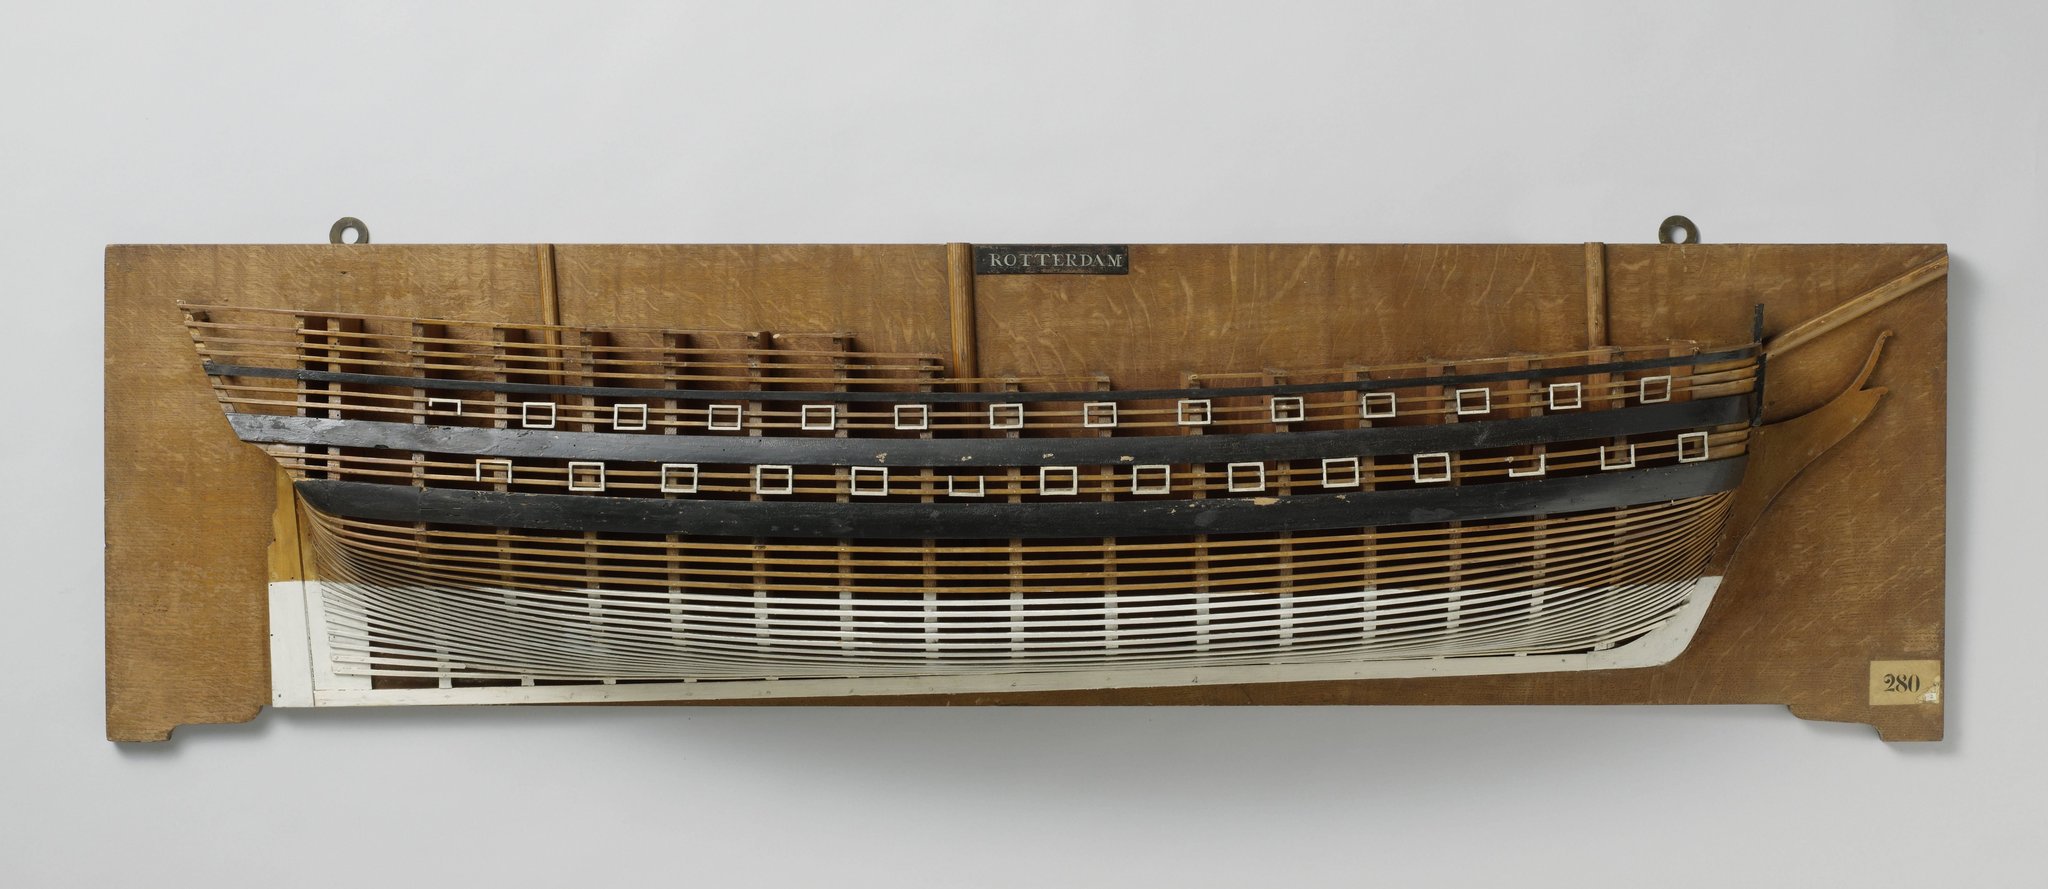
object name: ship model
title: Half Model of a 90-Gun Ship of the Line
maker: Anonymous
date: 1804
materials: wood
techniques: polychromy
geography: netherlands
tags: piet hein (schip), de ruyter (schip), koninklijke hollander (schip), hollandais (schip)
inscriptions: inscription, top centre, on a square black metal label: ‘ROTTERDAM’, label, bottom right: ‘280’ former inventory label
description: Gepolychromeerd mallenmodel (stuurboord) van een driemaster. Vijfendertig geschutpoorten verdeeld over drie dekken. Gewrongen spiegel, hol wulf, geen hek of zijgalerij; recht roer met vierkante roerkoning. De zeeg loopt op aan beide uiteinden, twee berghouten en één reehout. Het onderwaterschip is een flauwe S-spant. Schaal ca. 1:55 (afgeleid).